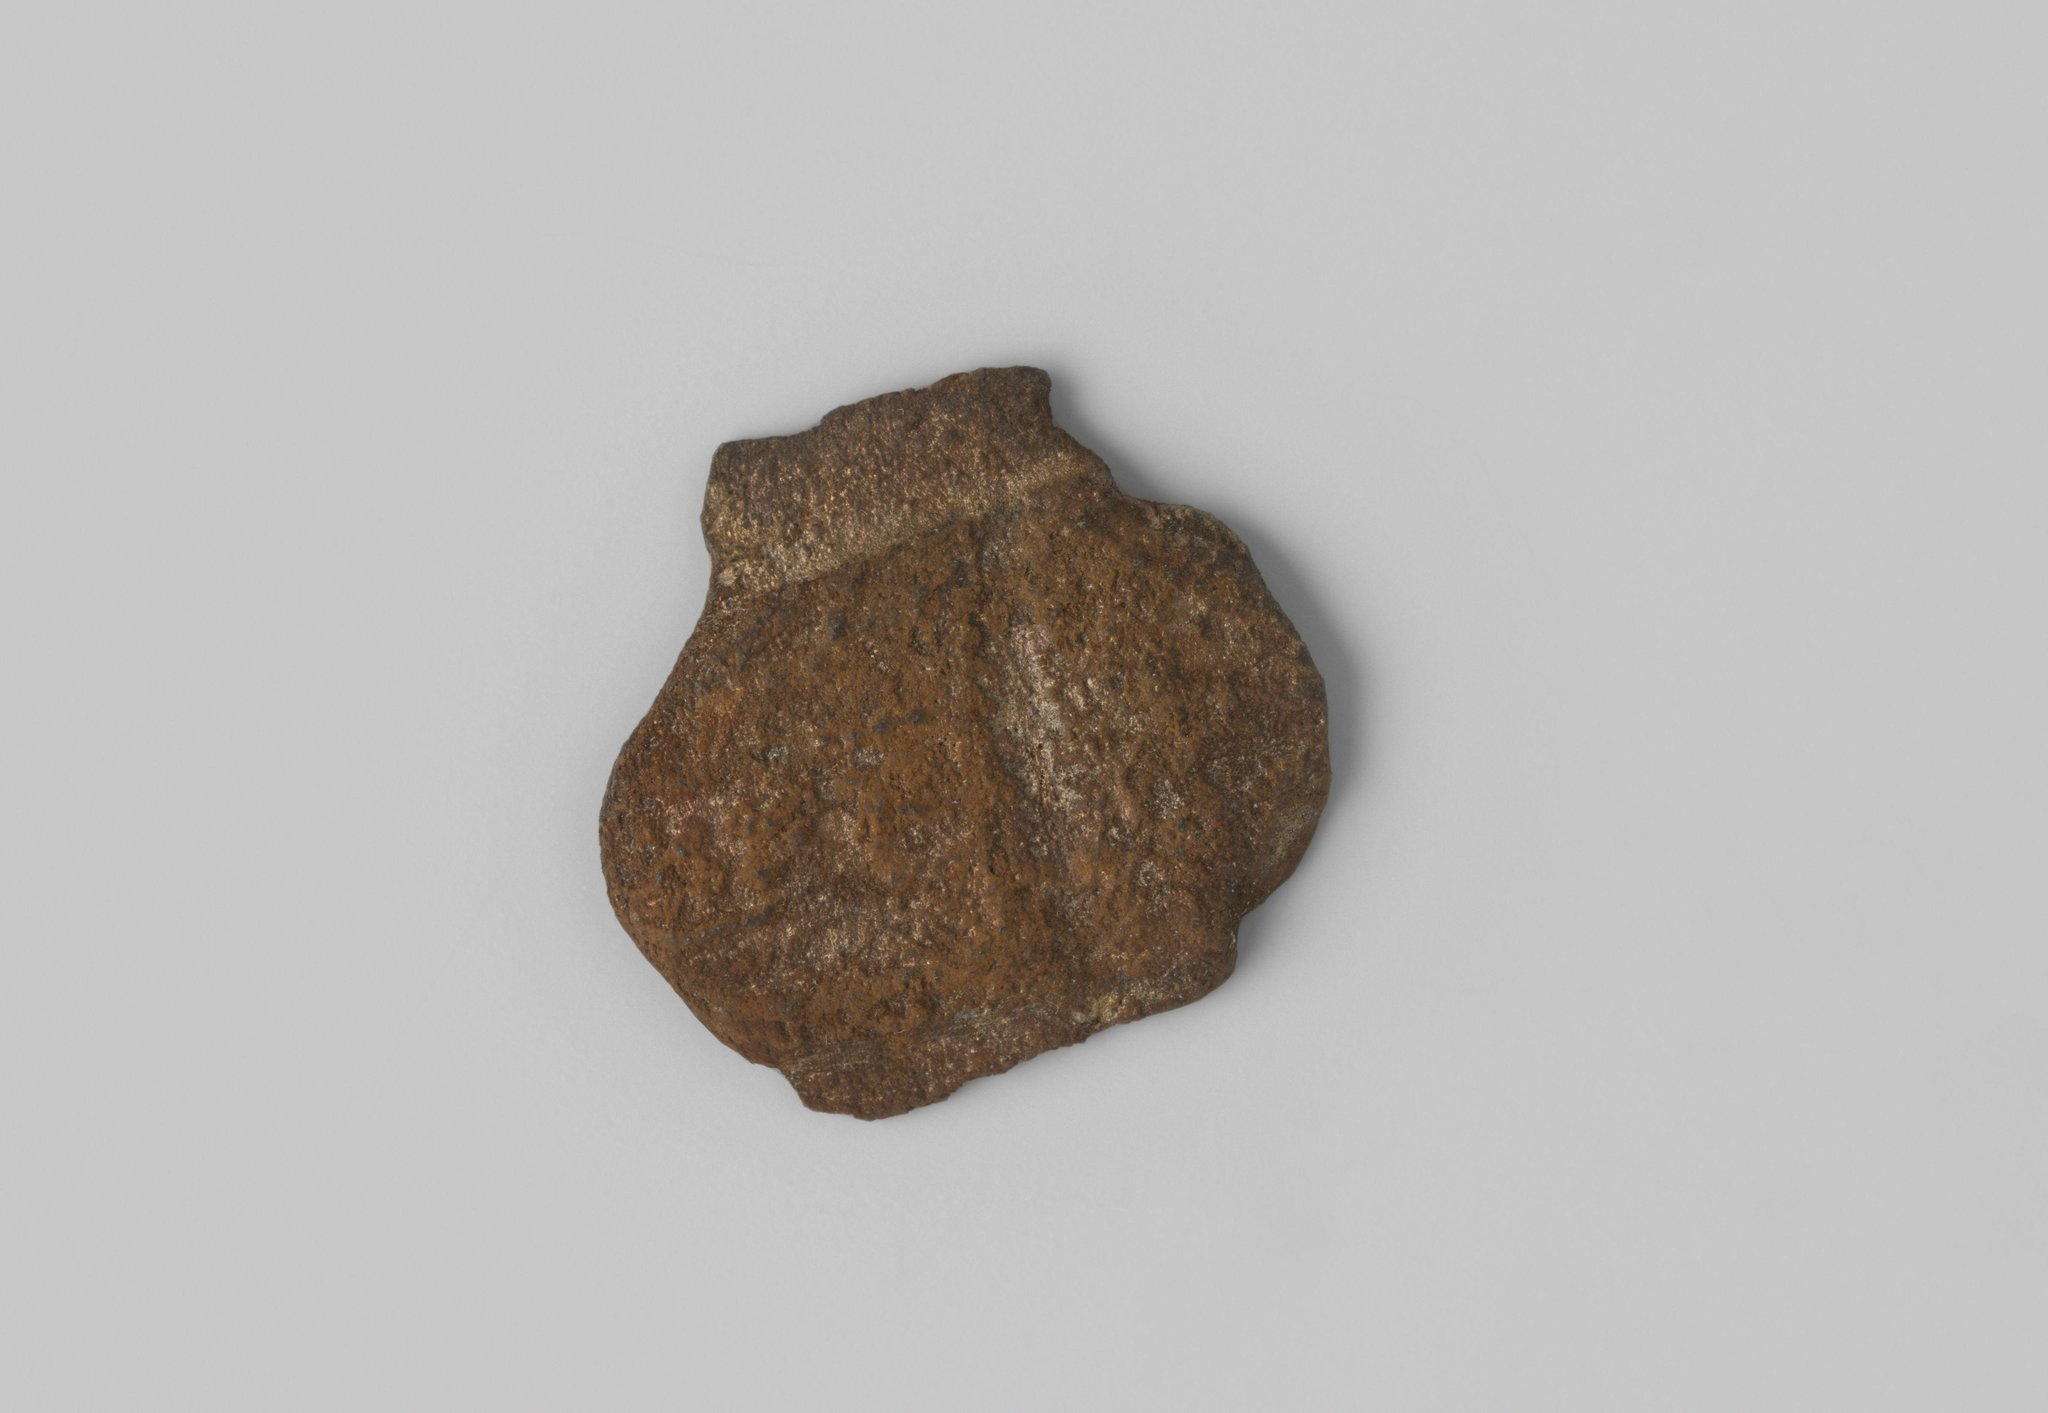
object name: schroefplaat, schroefblik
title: Fragmenten schroefplaat van een musket uit het wrak van de Oost-Indiëvaarder Hollandia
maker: Anonymous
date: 1700-1743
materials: copper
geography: netherlands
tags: verenigde oostindische compagnie, hollandia (schip), annet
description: Fragm, id. NG 1978-74H986 or NG 1980-27H3069, wings broken off, heavily corroded, side plate.